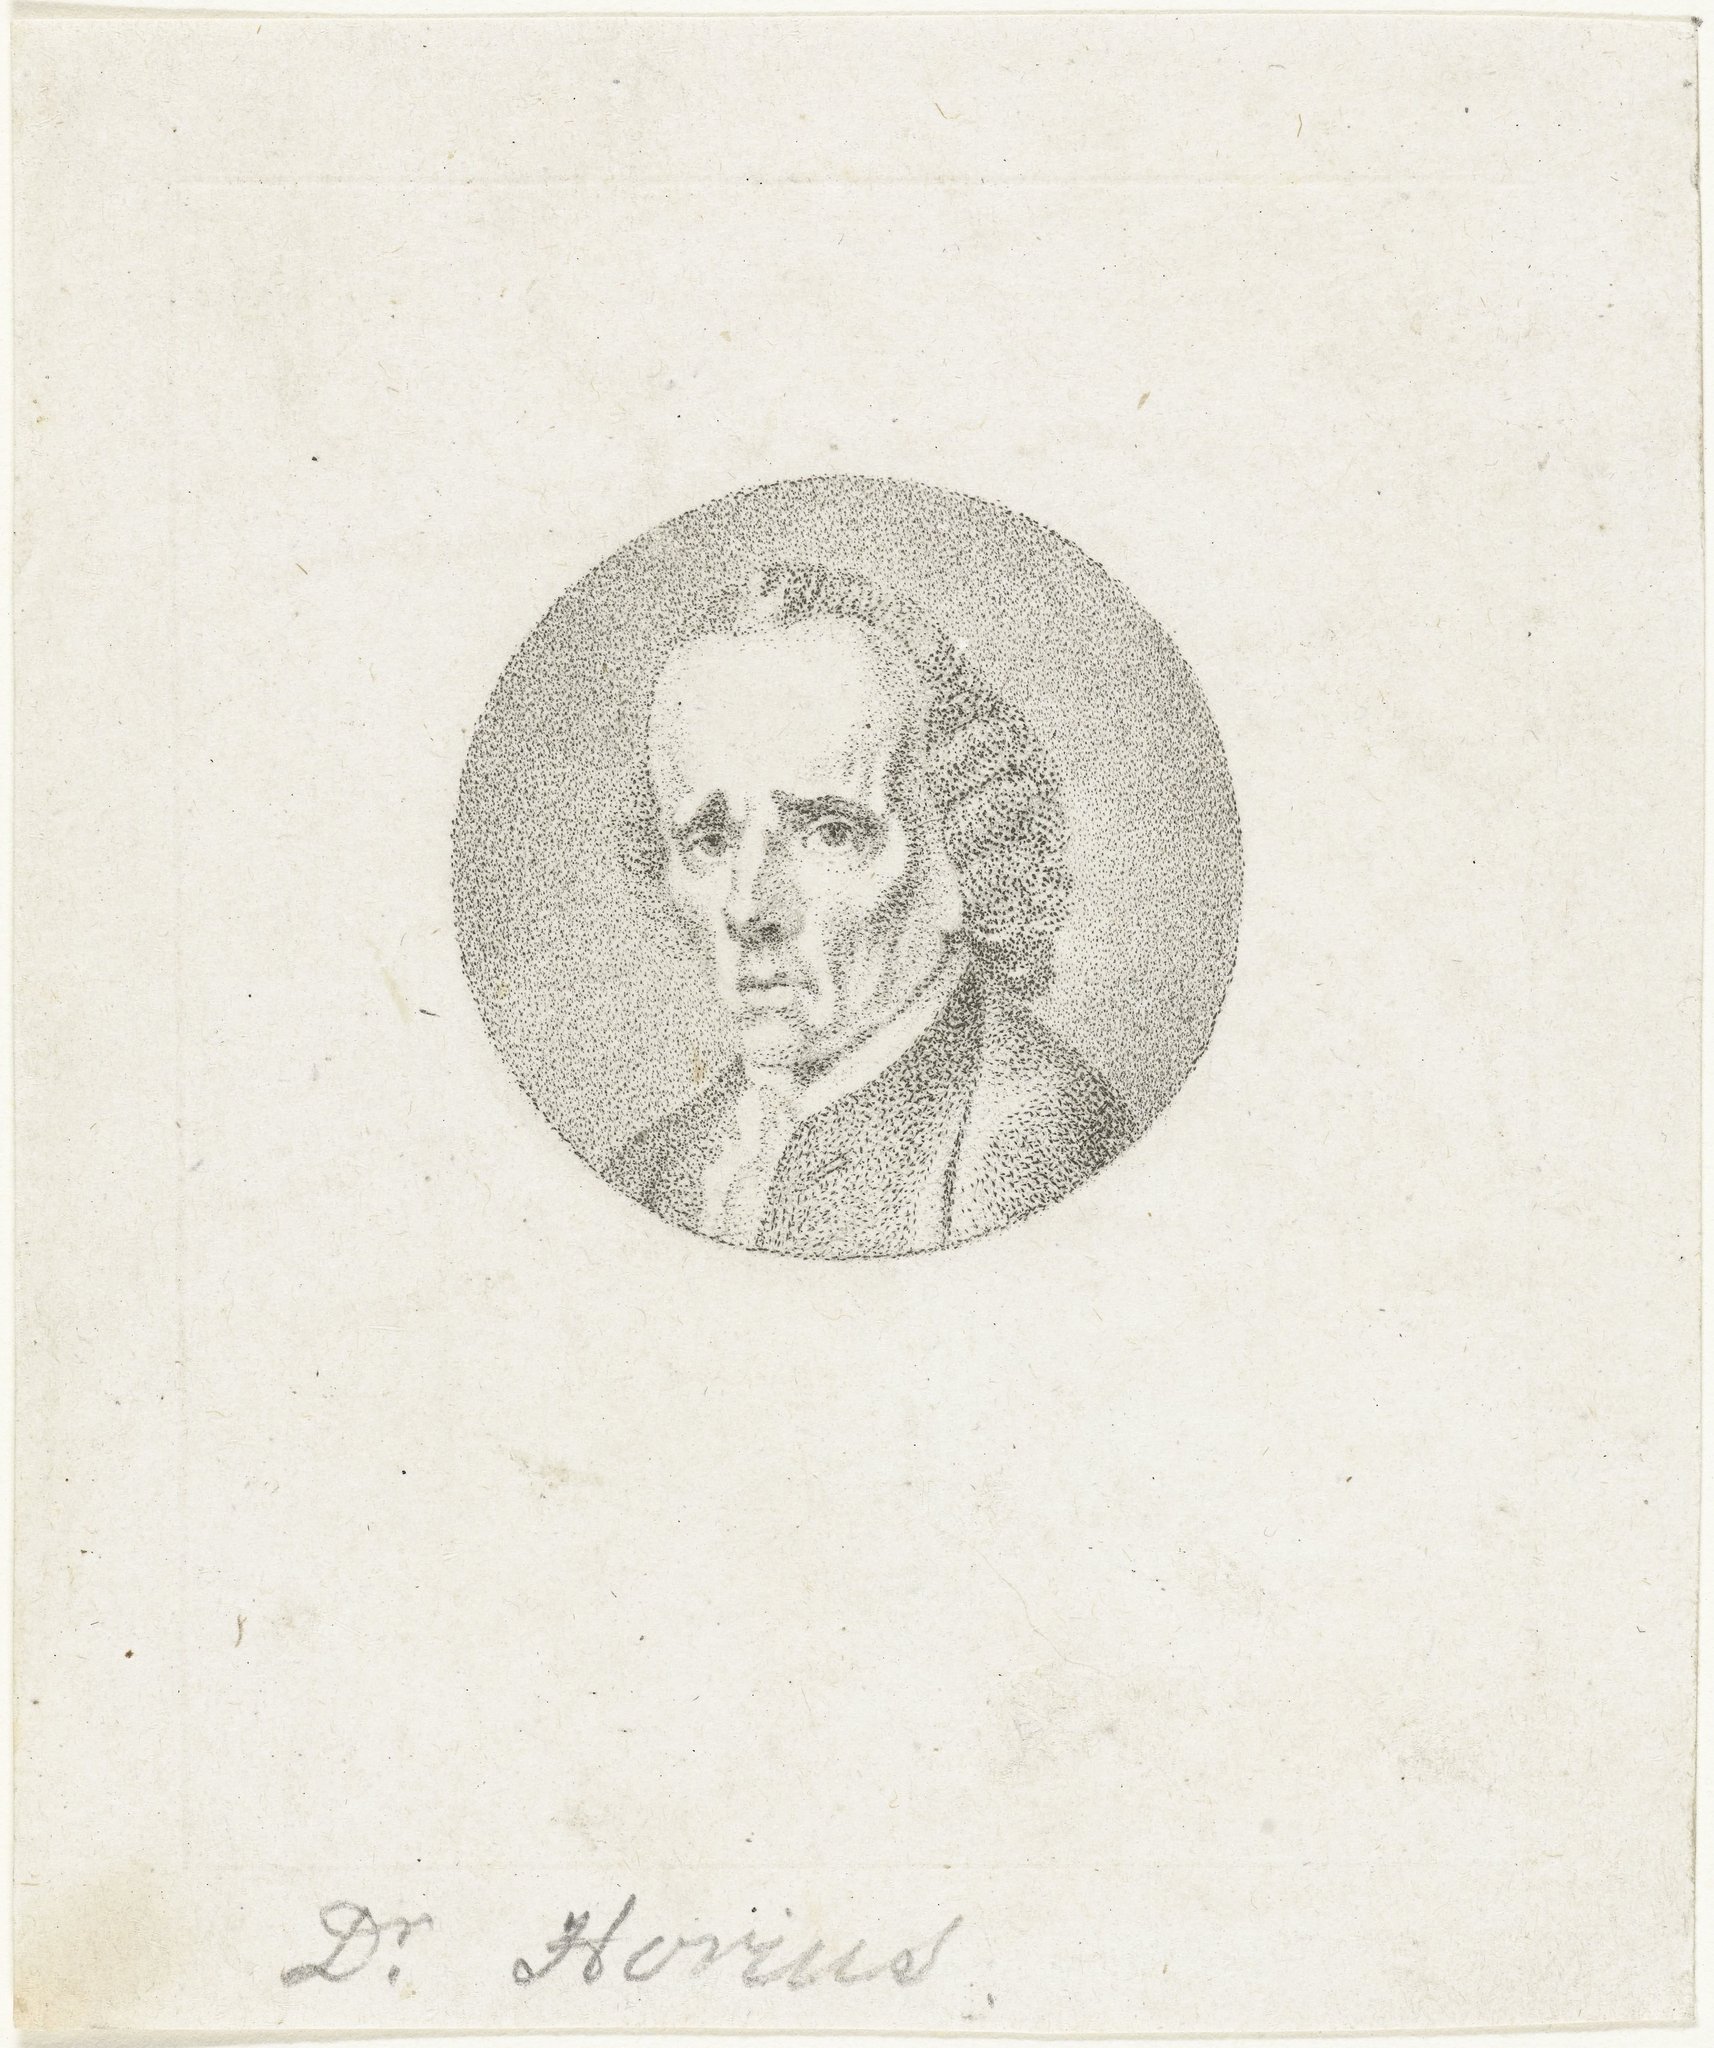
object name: print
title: Portret van Jacobus Hovius op 61-jarige leeftijd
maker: jacobus buys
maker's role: draughtsman, print maker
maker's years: 1724-1801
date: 1770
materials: paper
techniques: stippled etching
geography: amsterdam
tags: arts, jacobus hovius (1709-1786)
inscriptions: collector's mark: Lugt 2228